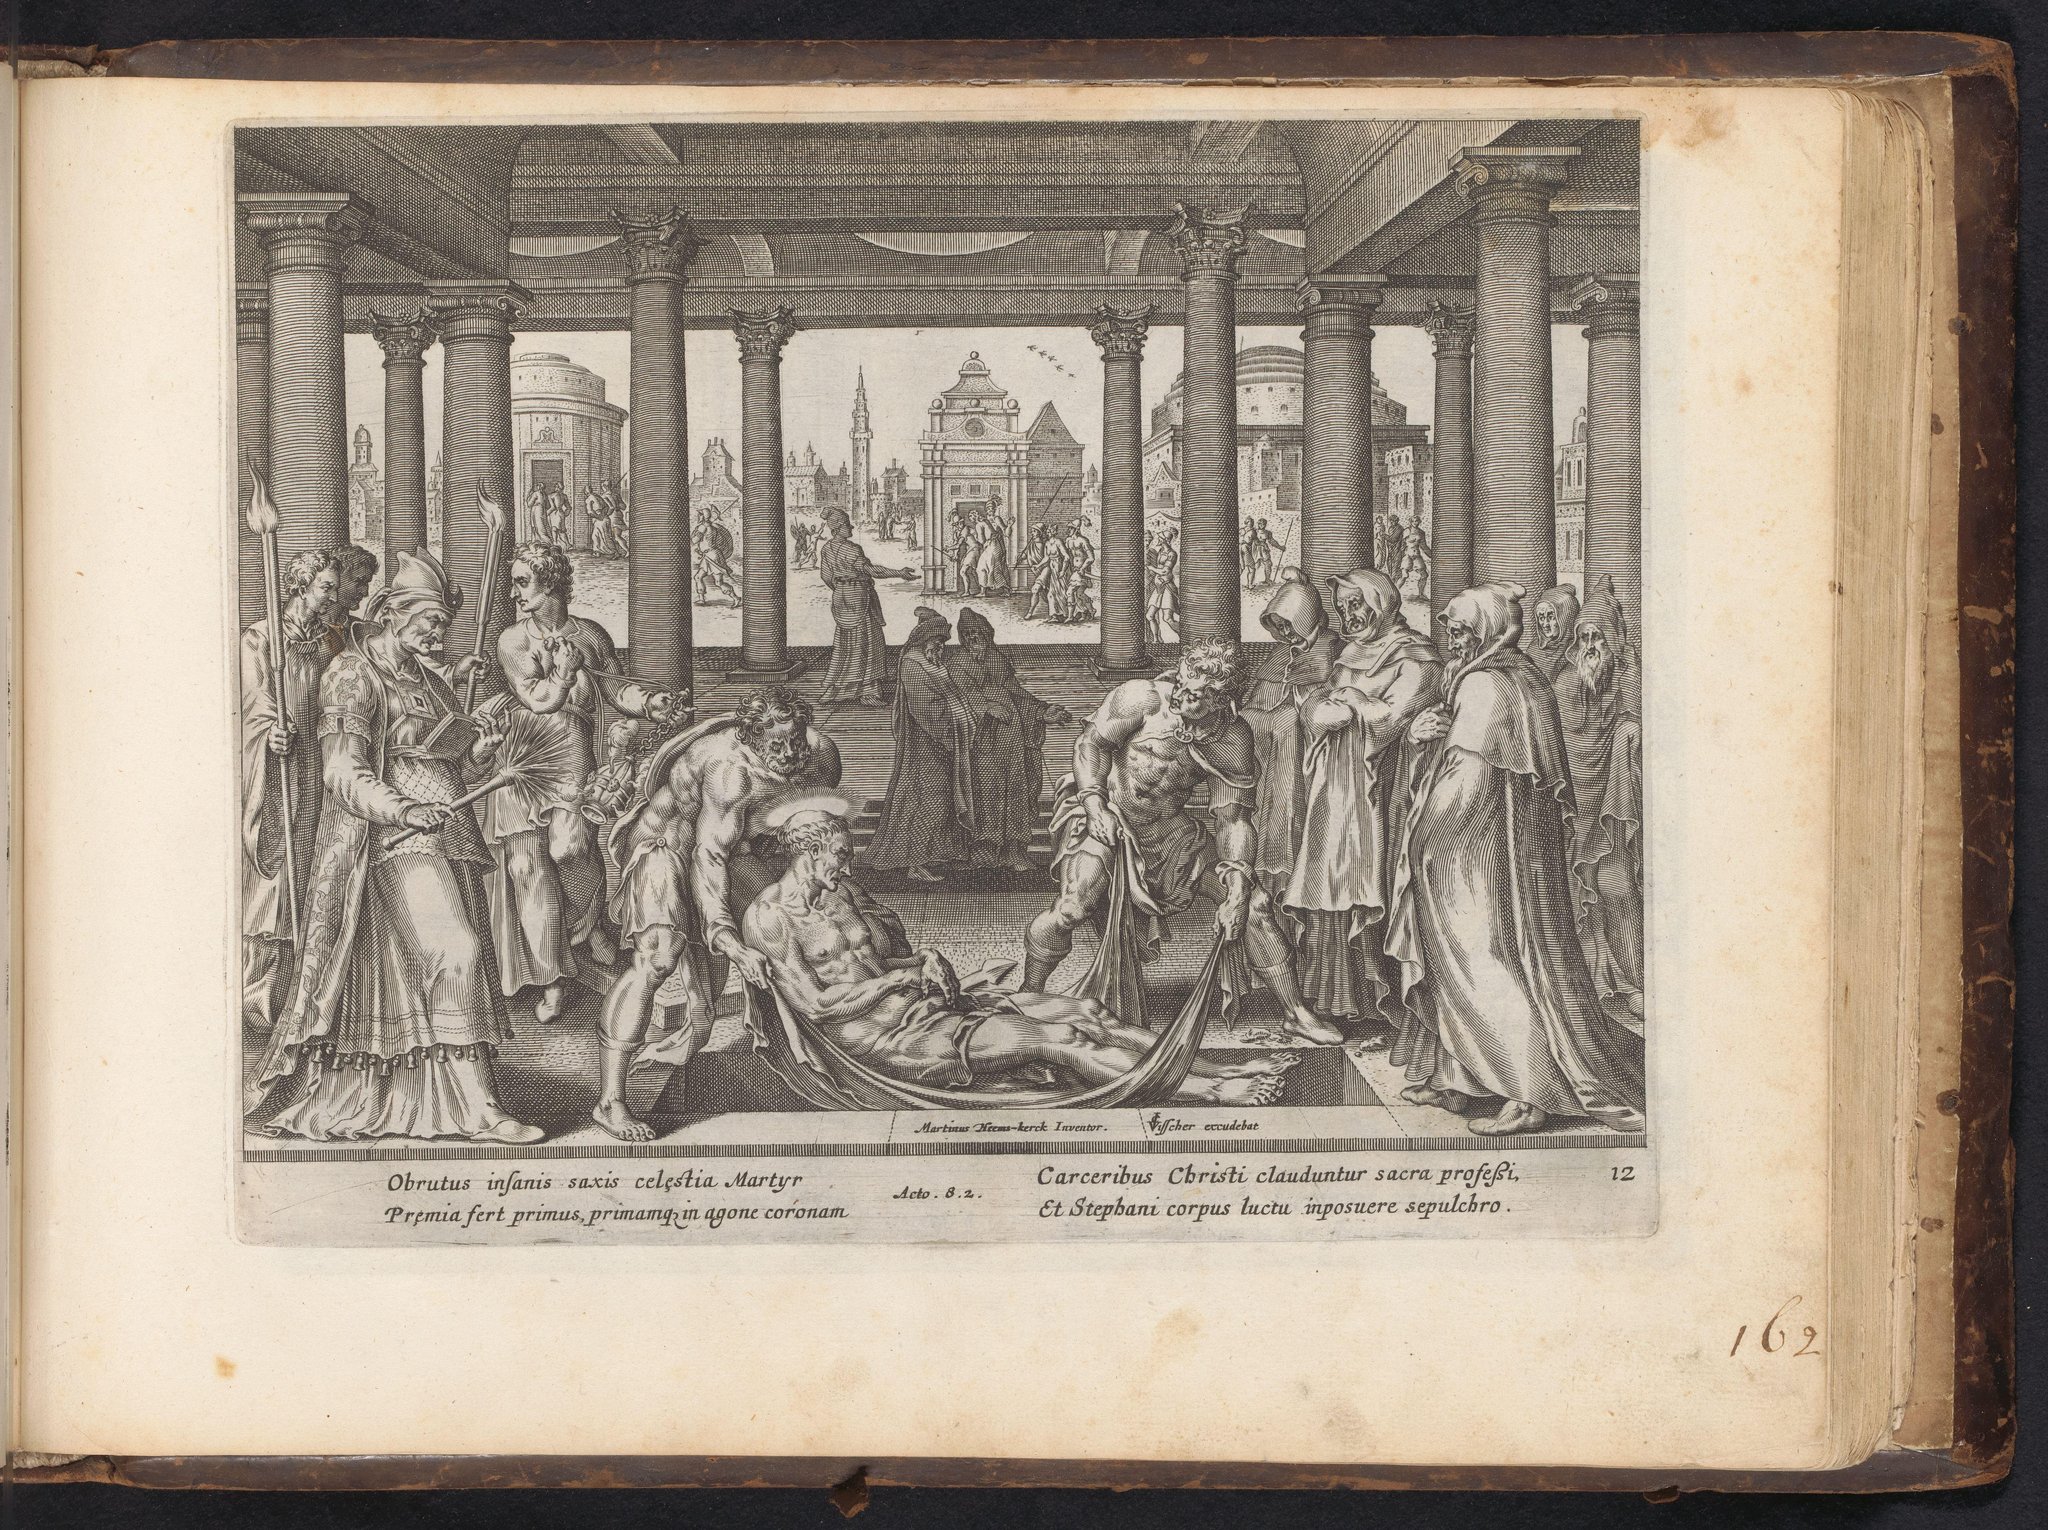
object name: album leaf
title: Graflegging van Stefanus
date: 1643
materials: paper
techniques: engraving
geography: alkmaar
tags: burial of stephen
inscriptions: number: ‘162’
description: Stefanus wordt in een lijkwade begraven. Onder de voorstelling een verwijzing in het Latijn naar de Bijbeltekst in Hand. 8:2. Deze prent maakt deel uit van een album.